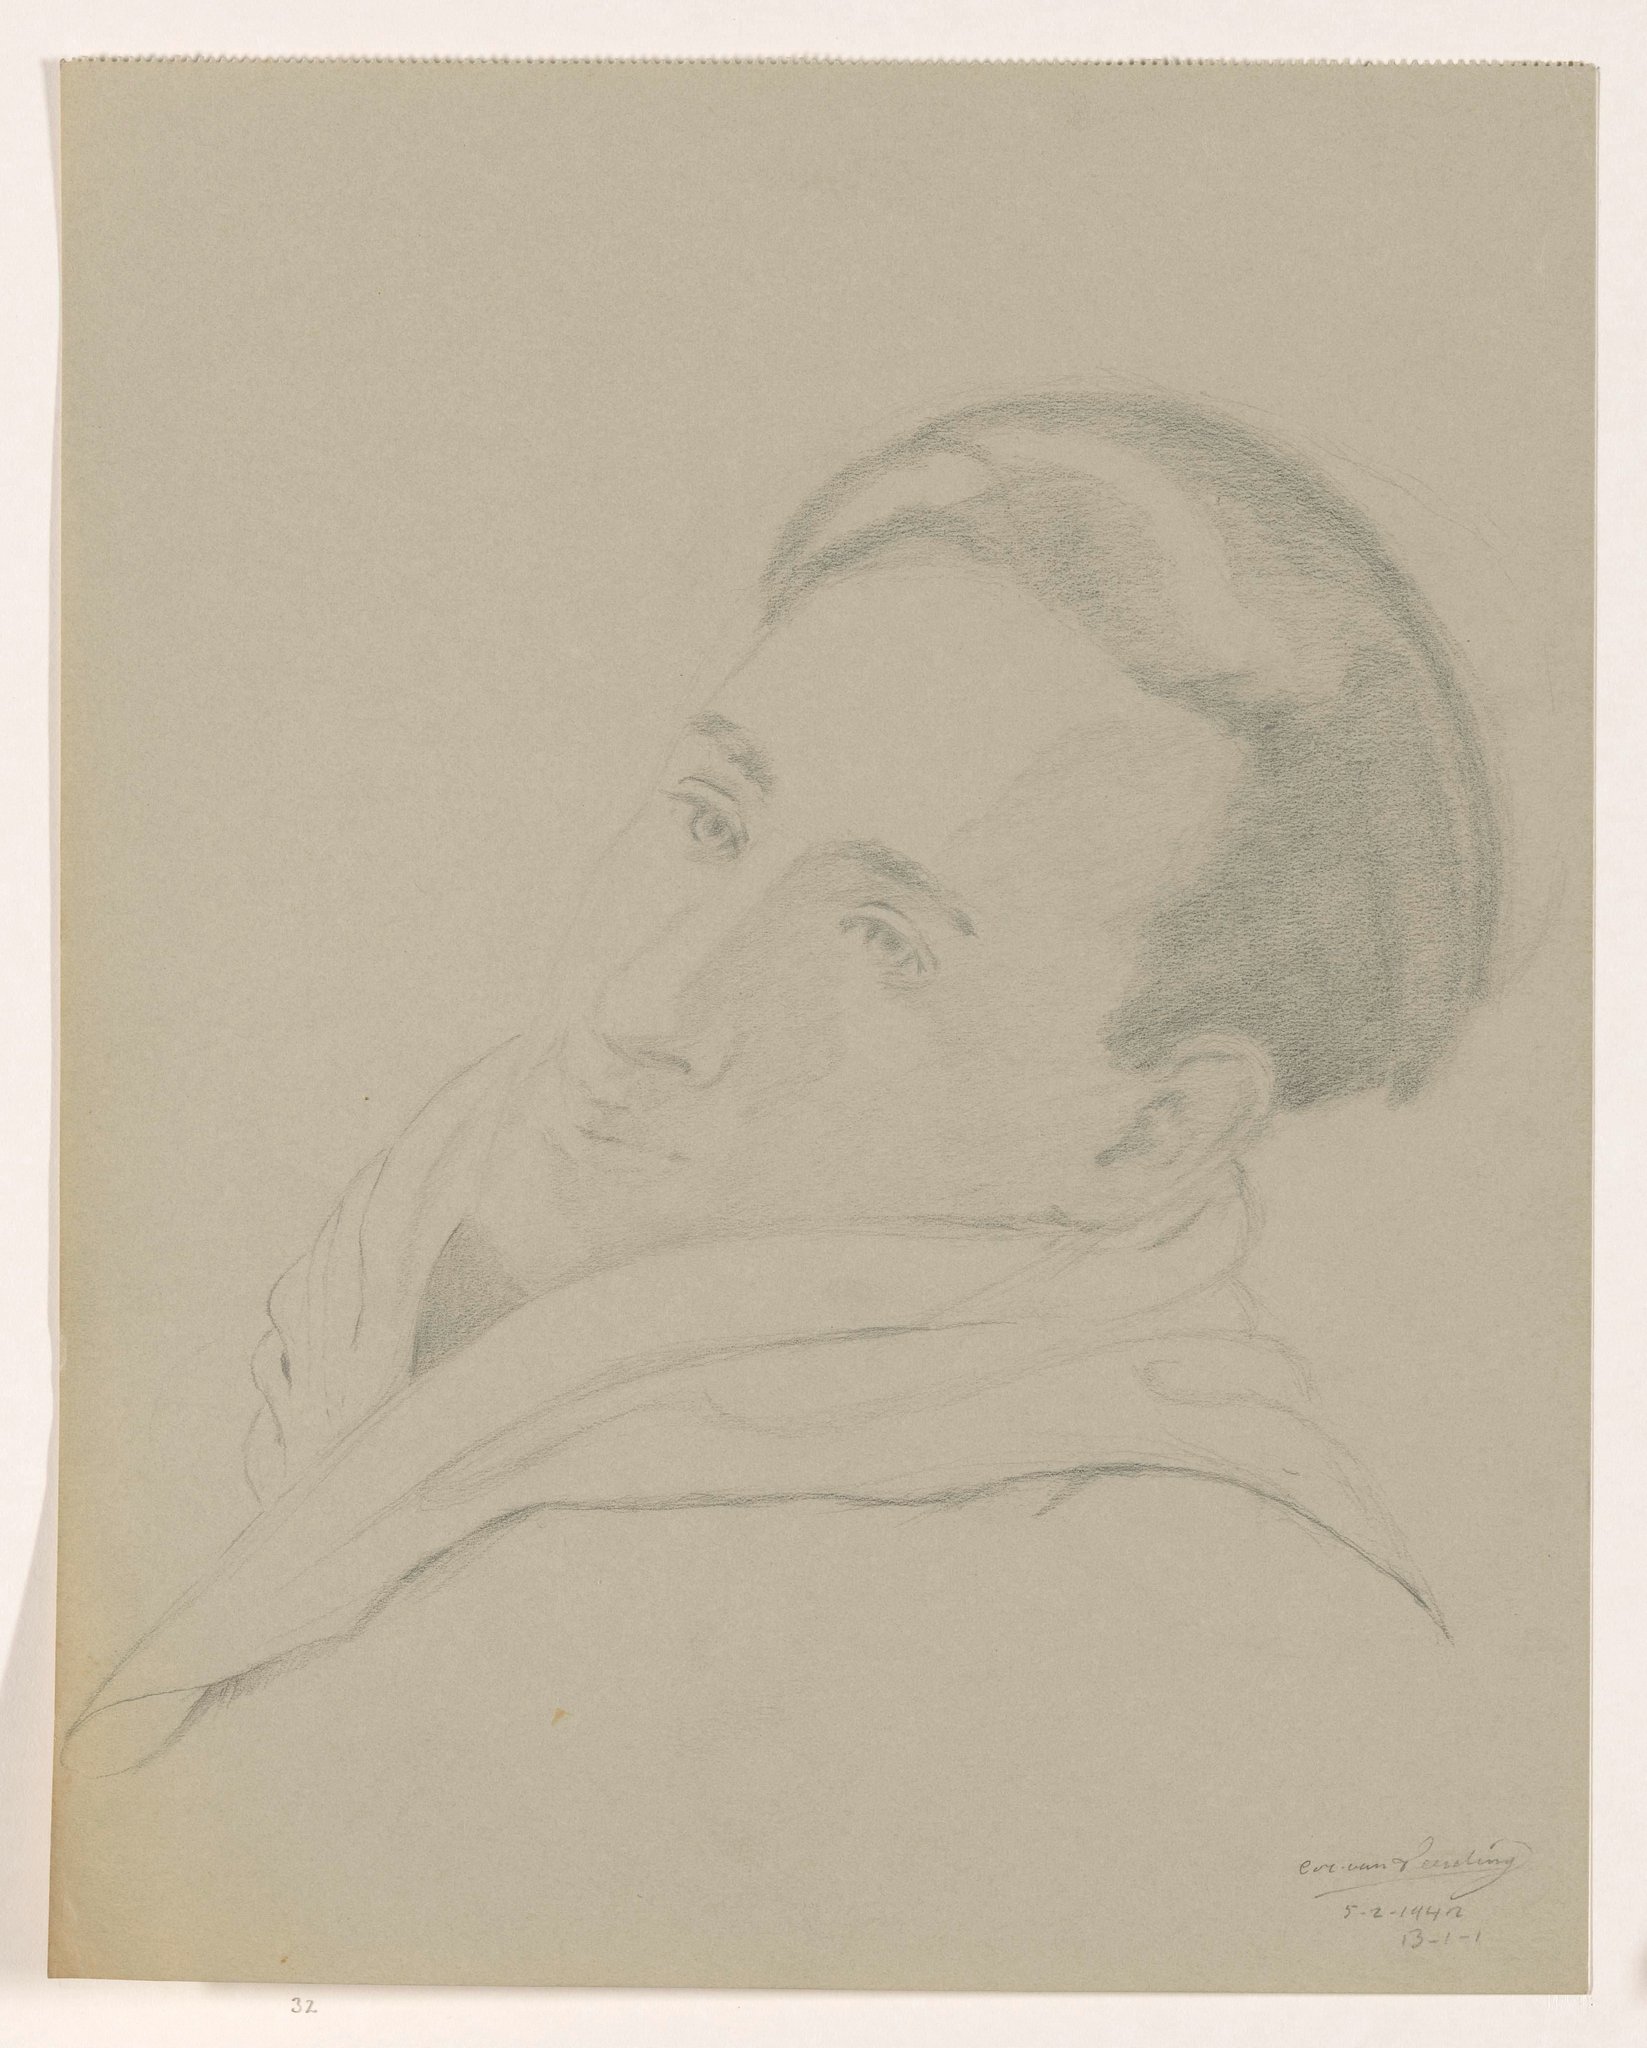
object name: drawing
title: Zelfportret: B-1-1, 5 februari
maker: cor van teeseling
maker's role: draughtsman, sculptor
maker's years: 1915-1942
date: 1942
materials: paper, pencil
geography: weteringschans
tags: amsterdam, draughtsman, sculptor, cor van teeseling, historical persons, prisoner in cell or locked place, portrait, self-portrait of draughtsman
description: Zelfportret van Cor van Teeseling: B-1-1, 5 februari. Getekend zelfportret van Cor van Teeseling driekwart met zijn hoofd achterover naar links gewend.